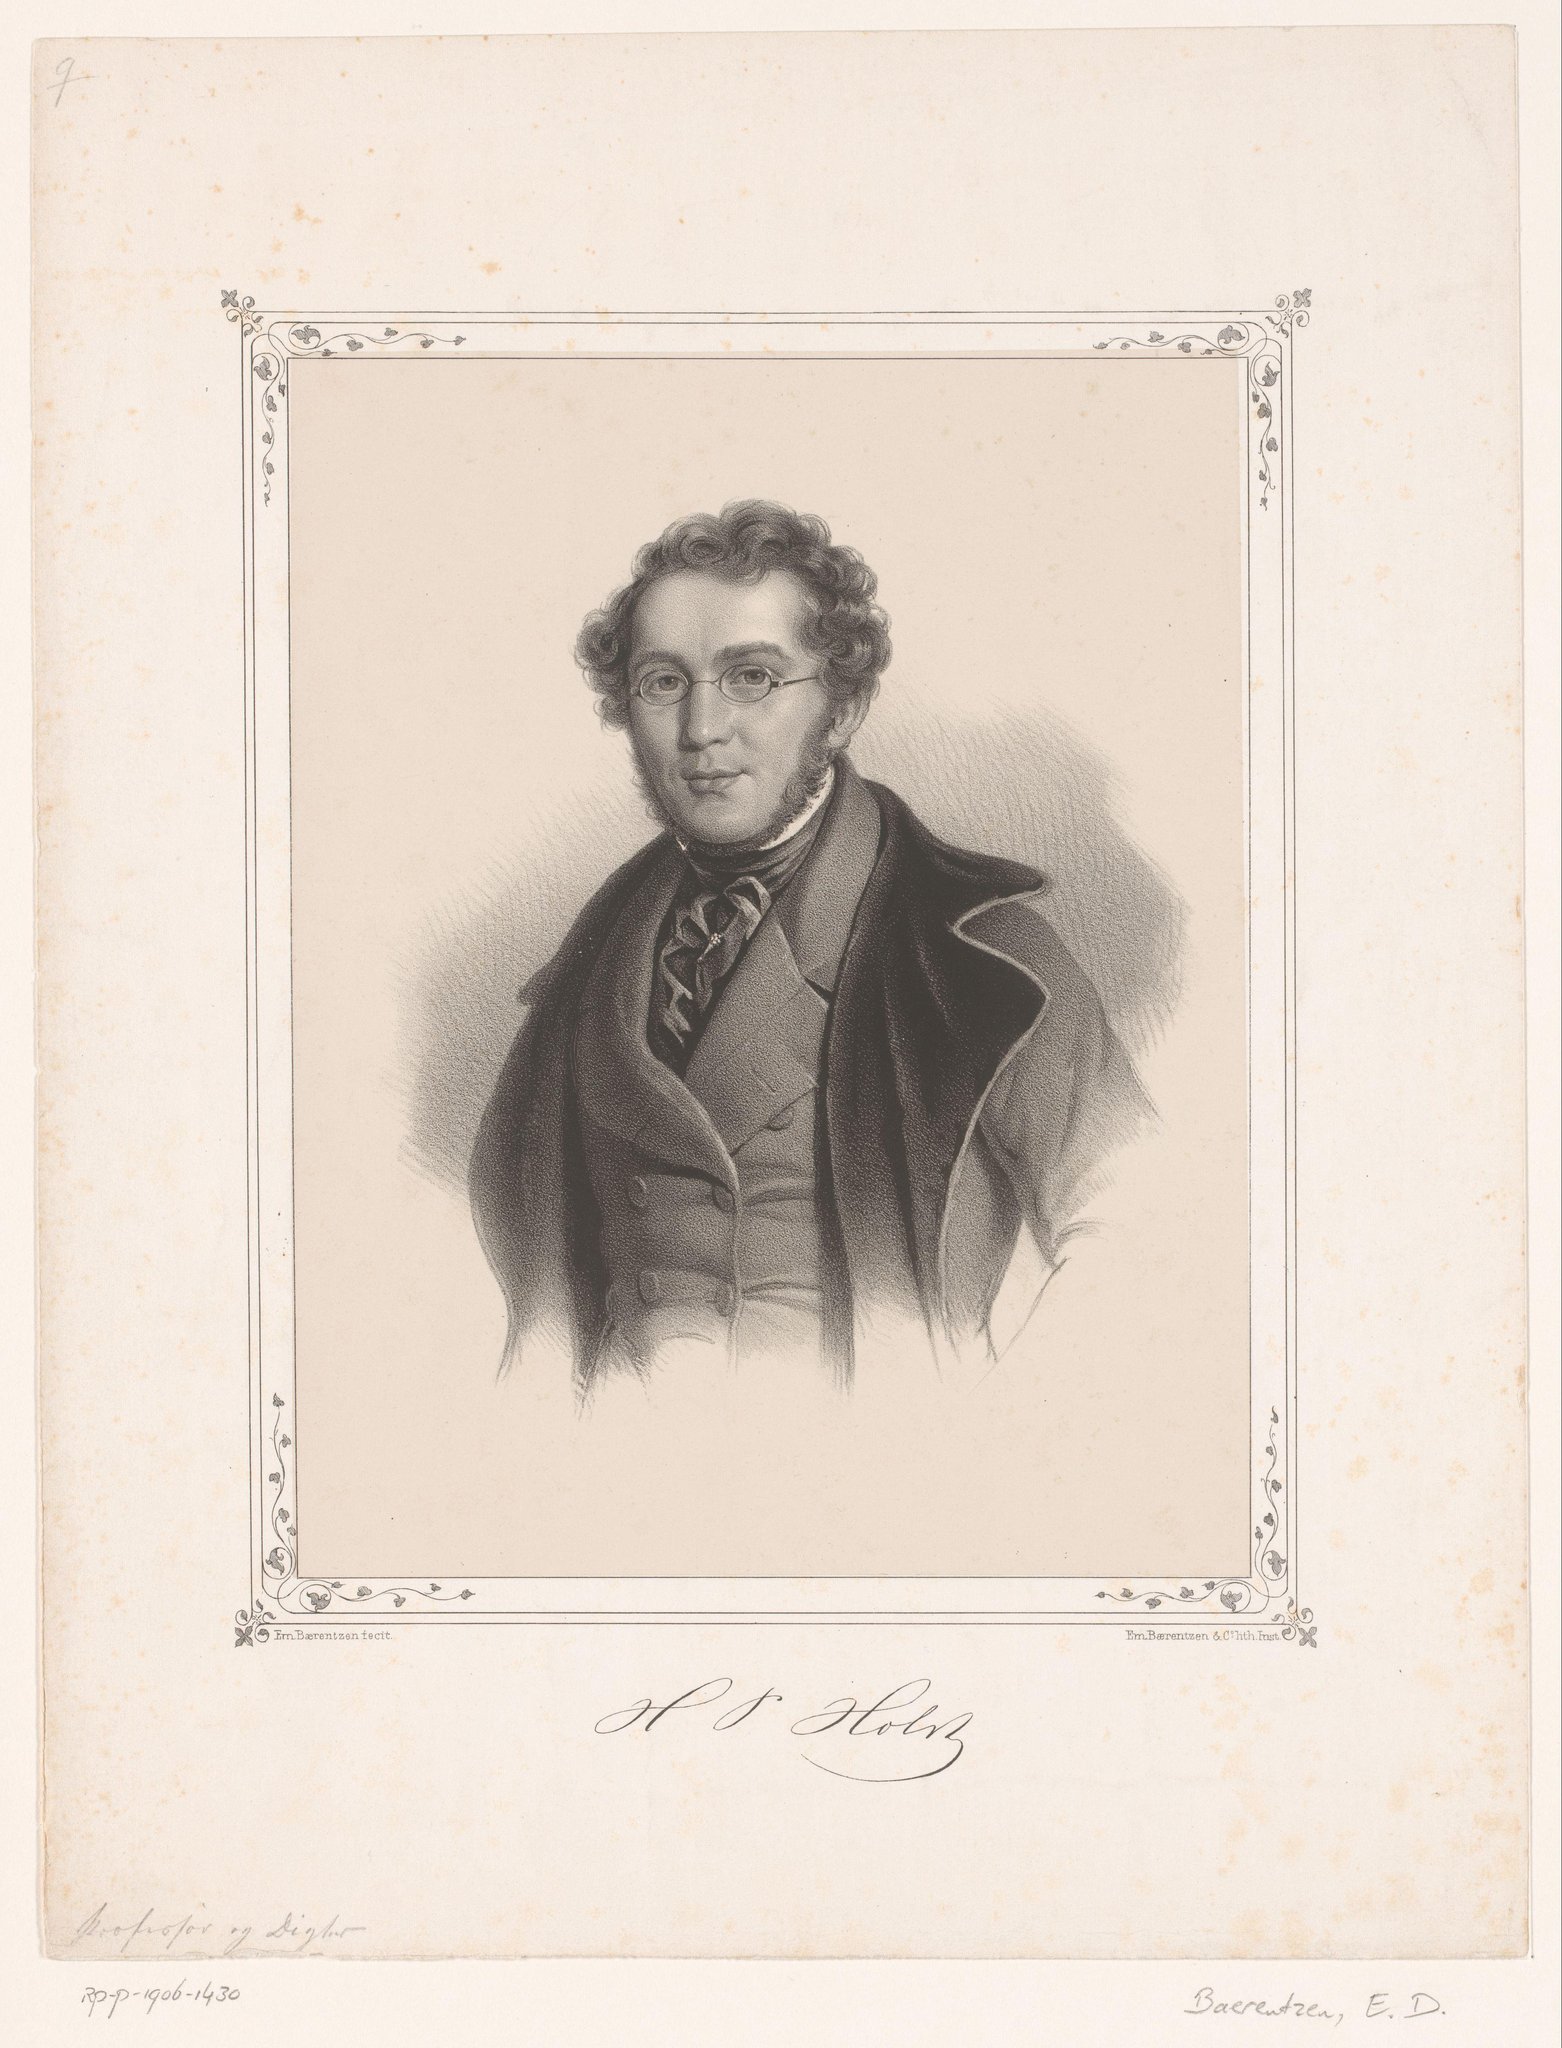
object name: print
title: Portret van Hans Peter Holst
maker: emilius ditlev baerentzen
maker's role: print maker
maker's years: 1799-1868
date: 1837-1868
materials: paper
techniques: lithograph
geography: copenhagen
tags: copenhagen (city), historical persons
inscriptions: inscription: ‘H P Holst’, inscription: ‘Em. Baerentzen & Co lith.Inst.’, inscription: ‘Em. Baerentzen fecit.’, collector's mark: Lugt 2228